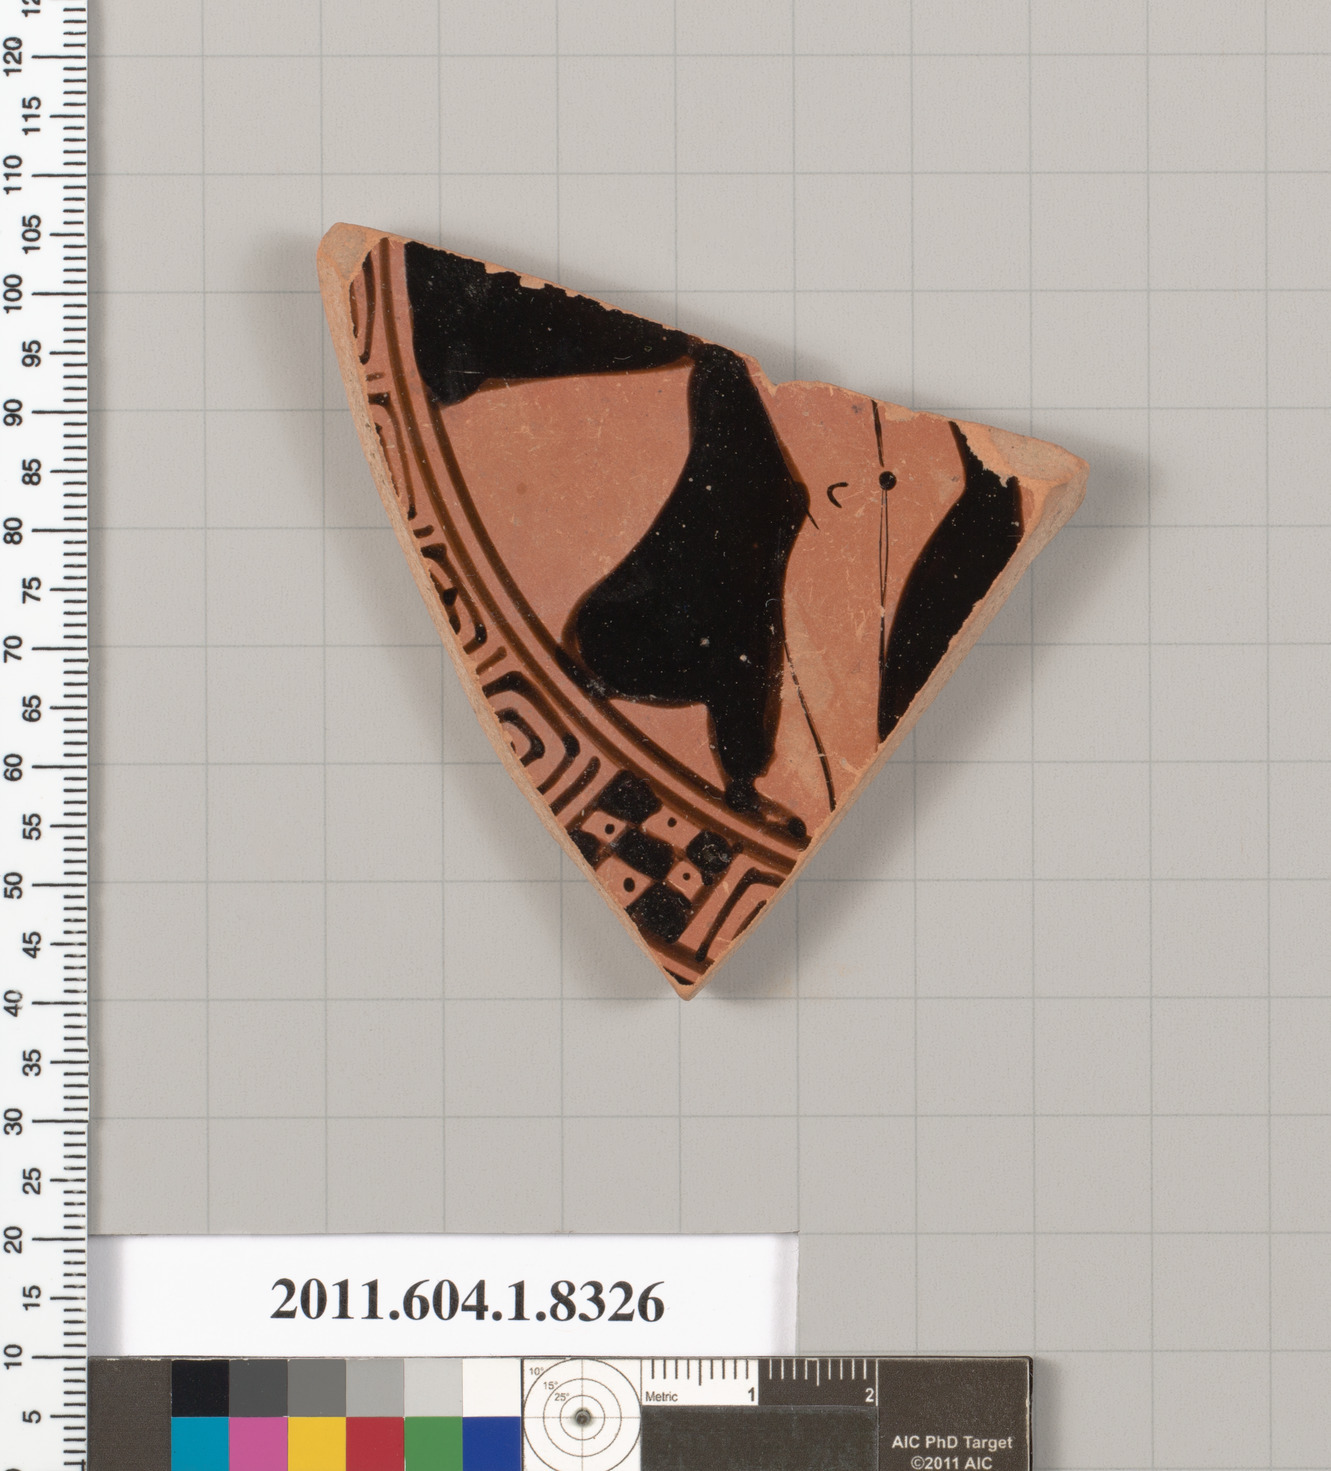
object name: kylix fragment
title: Terracotta fragment of a kylix (drinking cup)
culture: greek, attic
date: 434-401 BCE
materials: terracotta